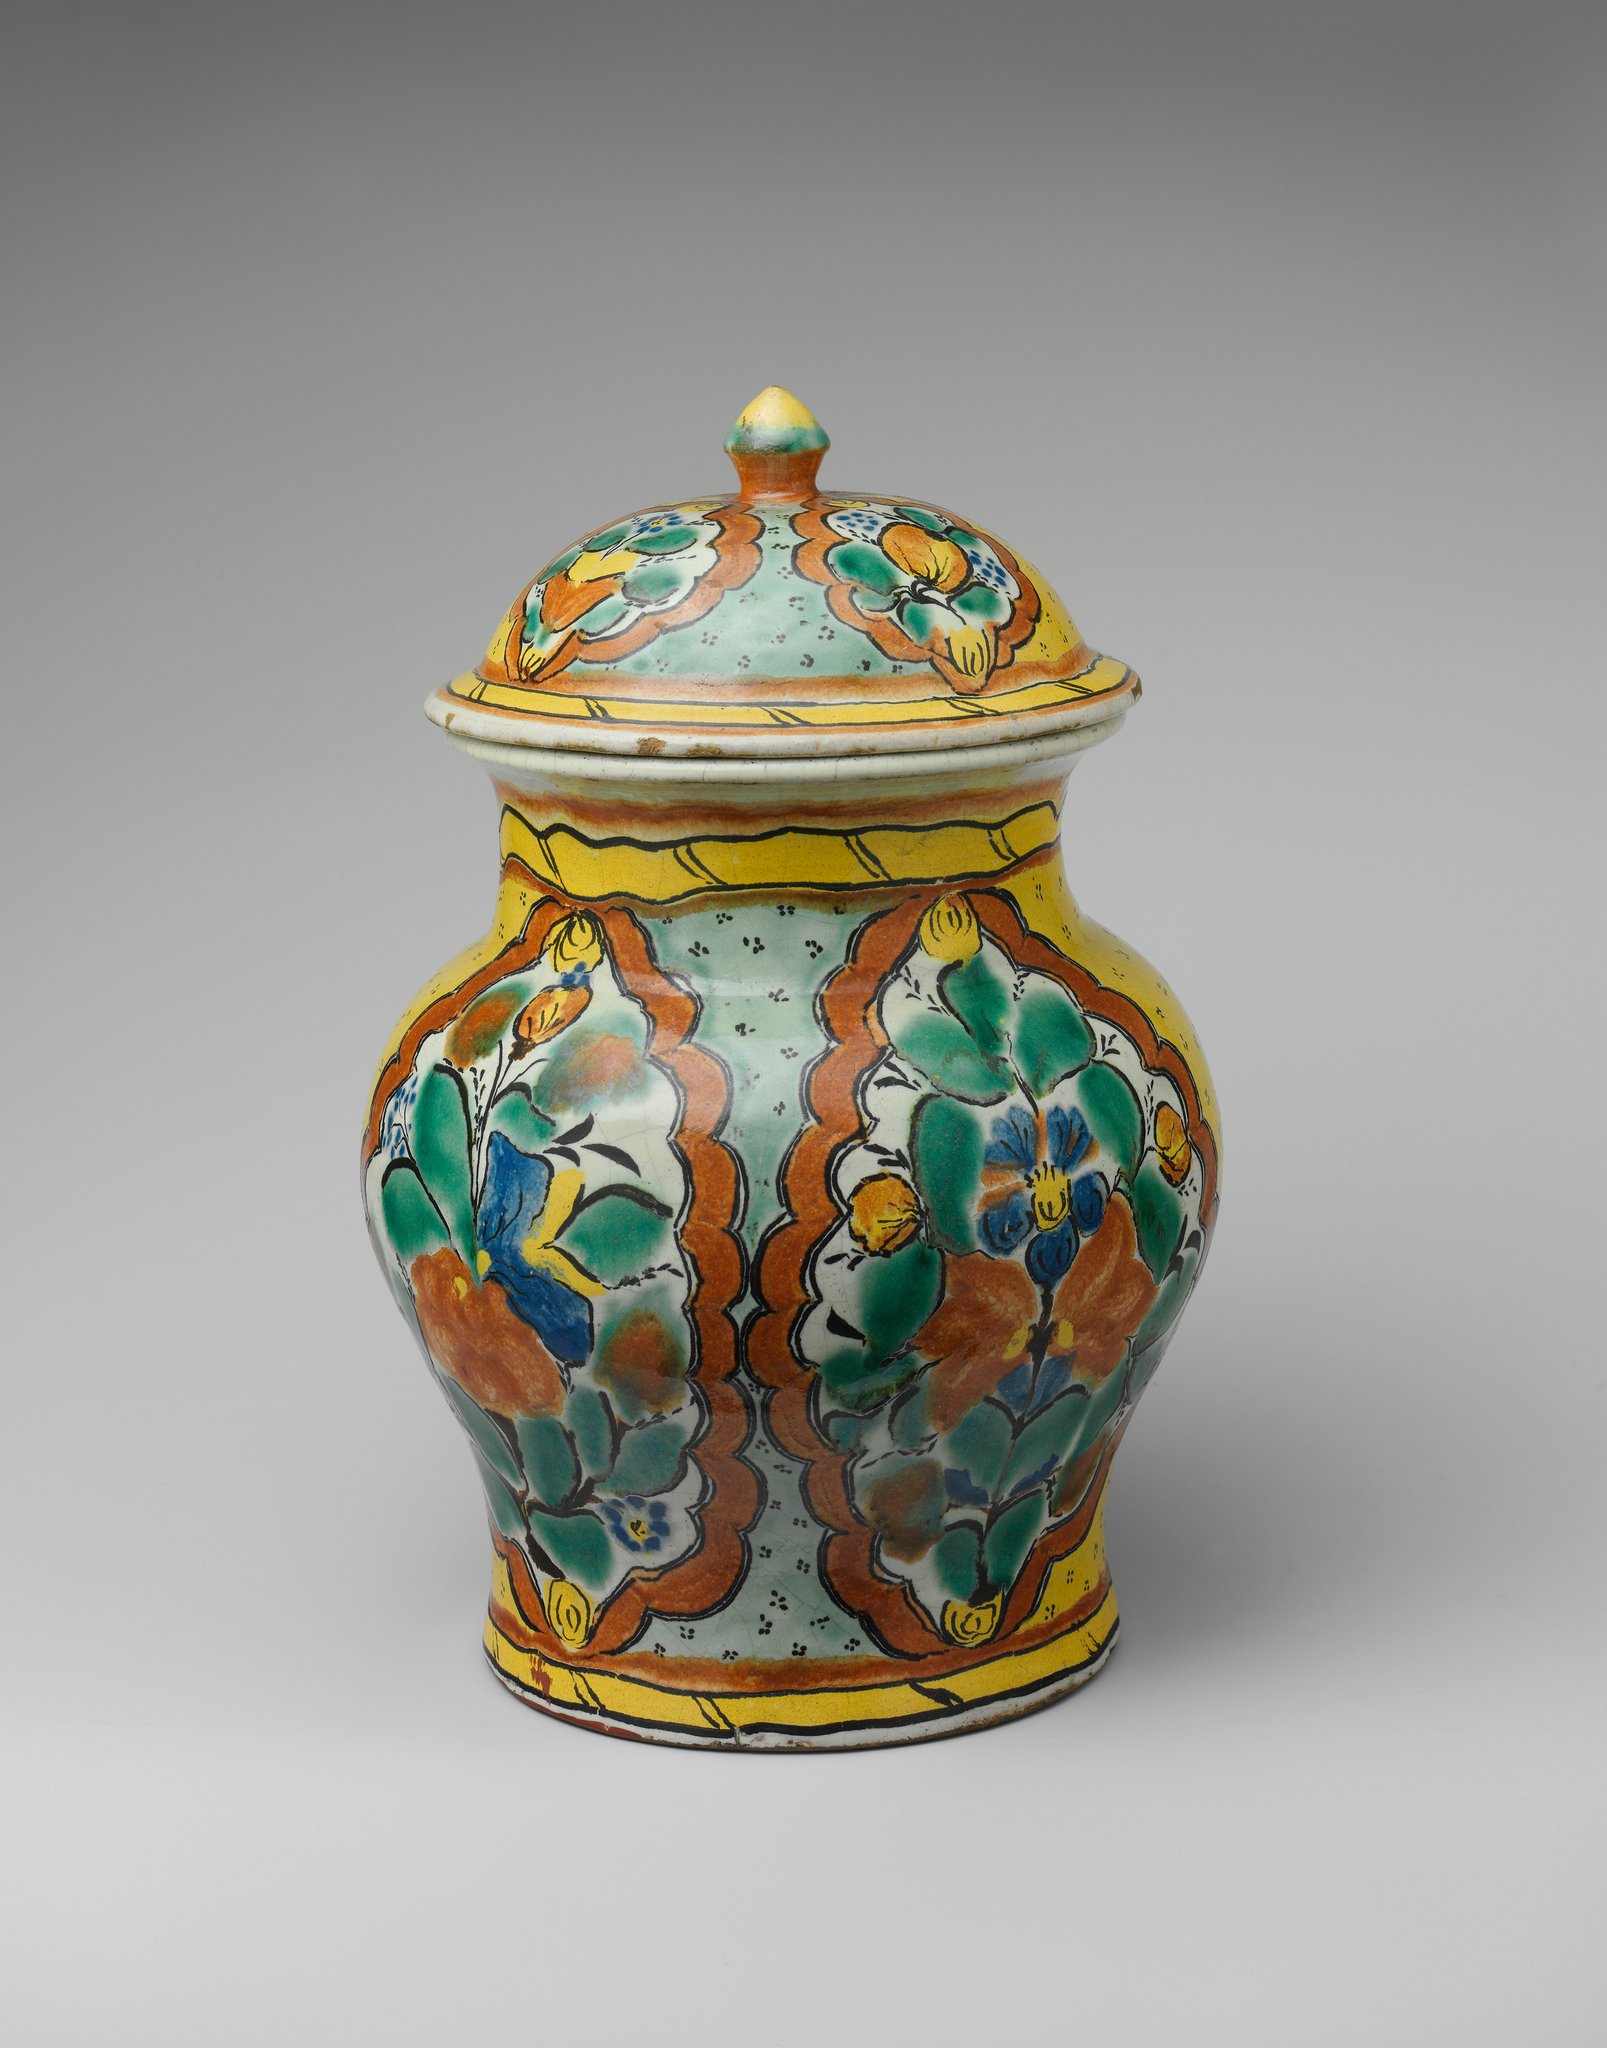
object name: jar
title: Covered Jar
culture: mexican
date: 1840-1860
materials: earthenware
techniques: glazing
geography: mexico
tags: flowers